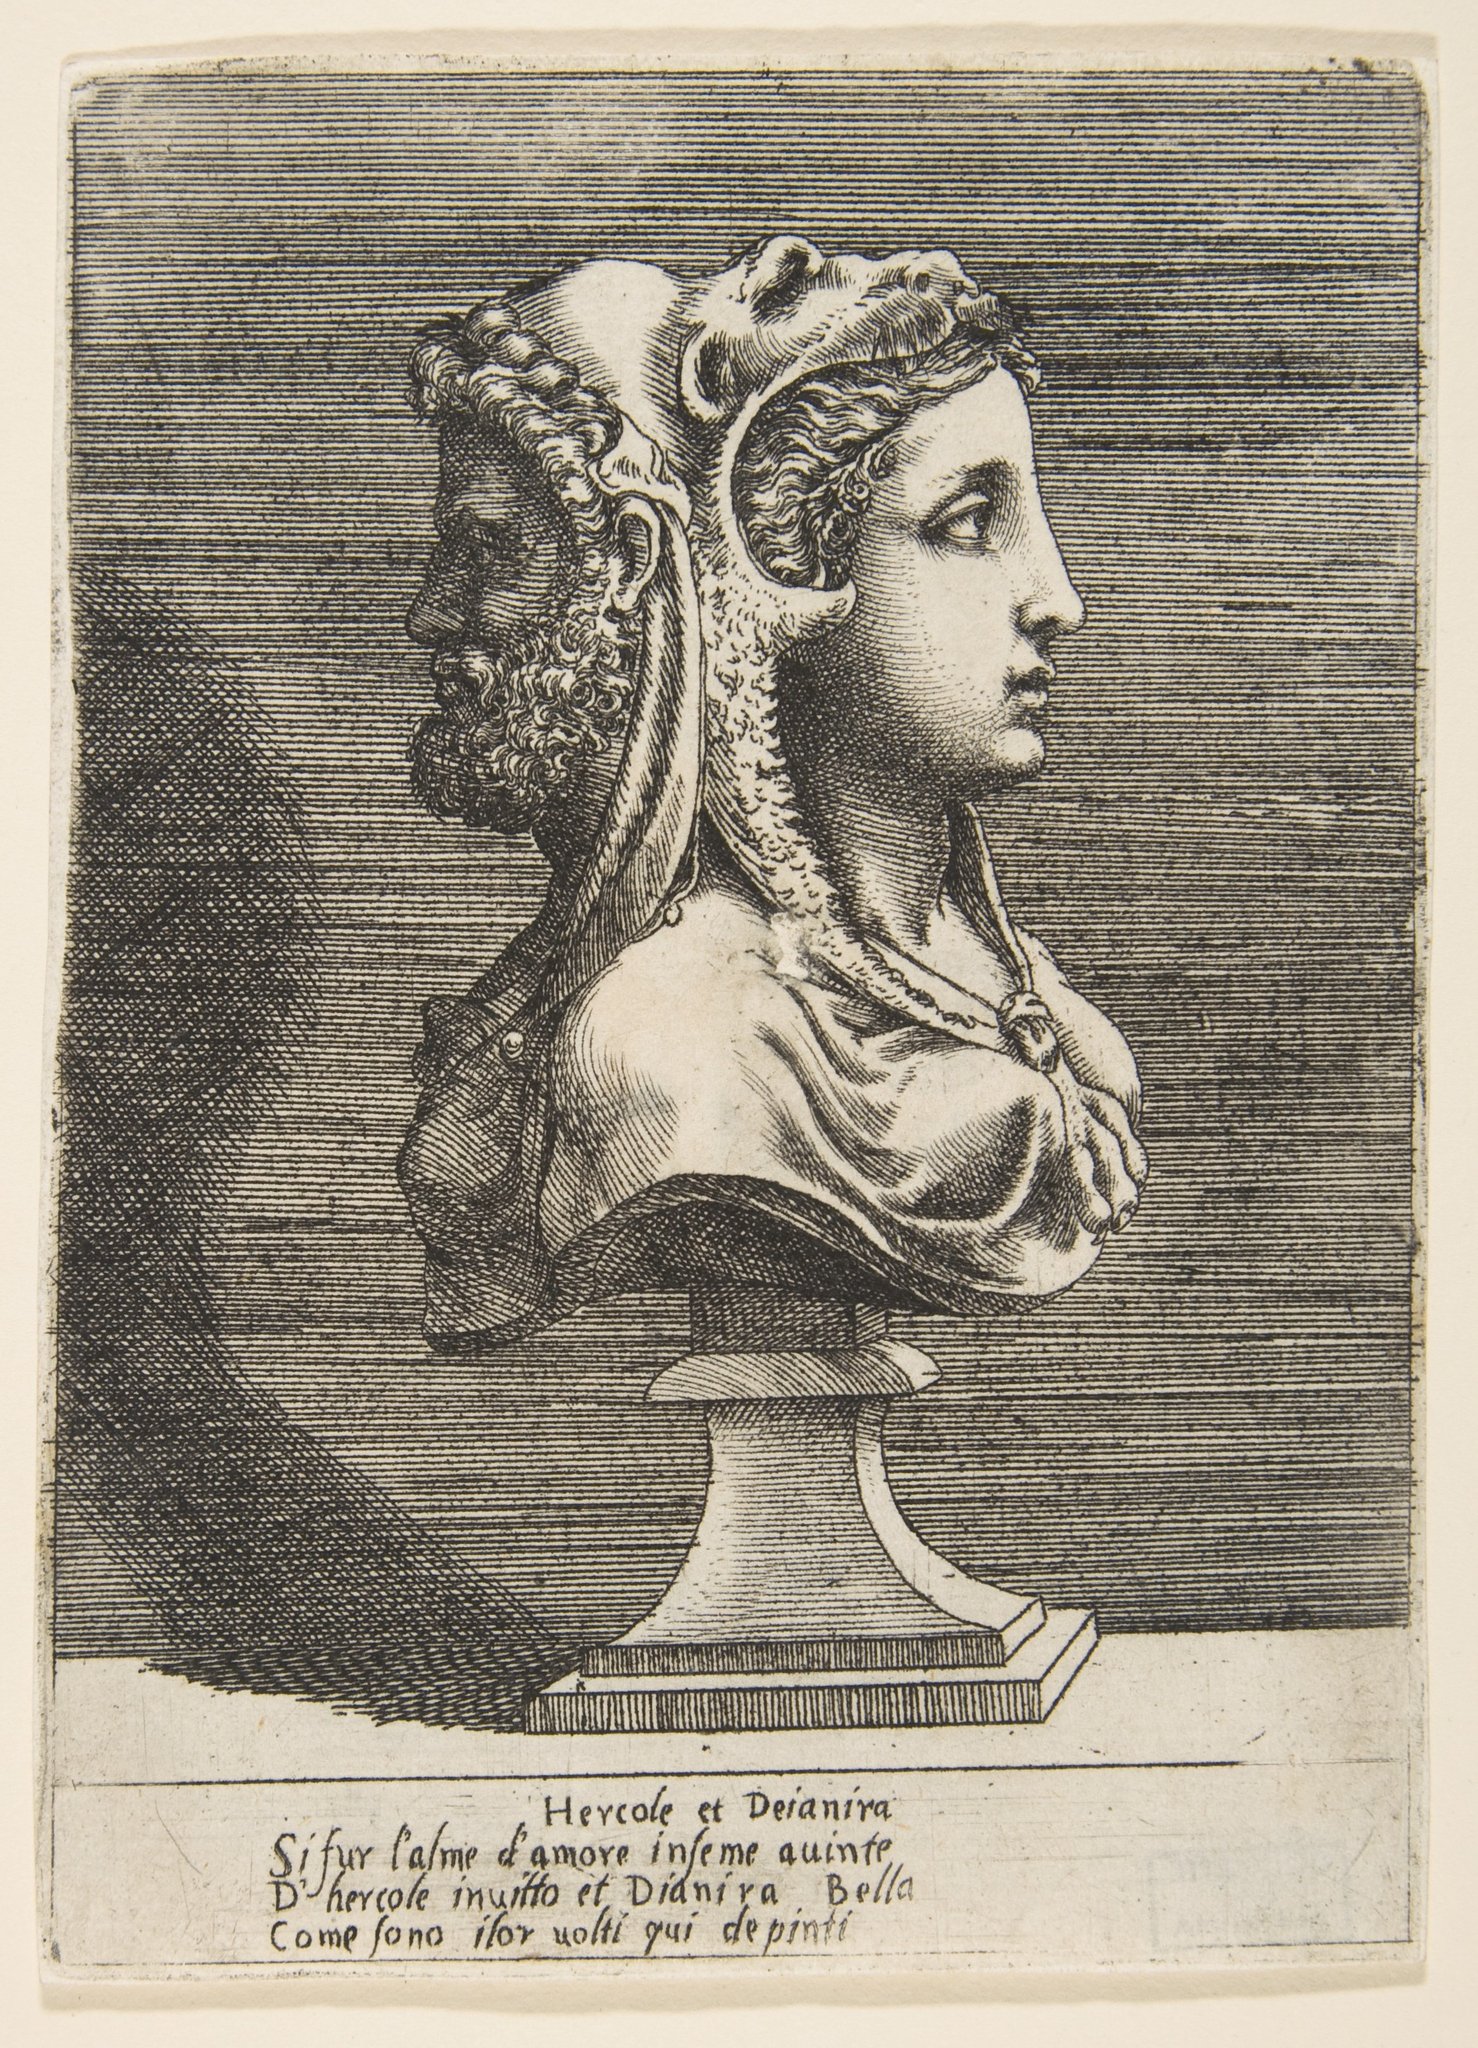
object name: print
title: Bust of Hercules and Dejanira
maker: giulio bonasone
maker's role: artist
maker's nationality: italian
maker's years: 1510-1576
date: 1531-1576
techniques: engraving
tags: hercules